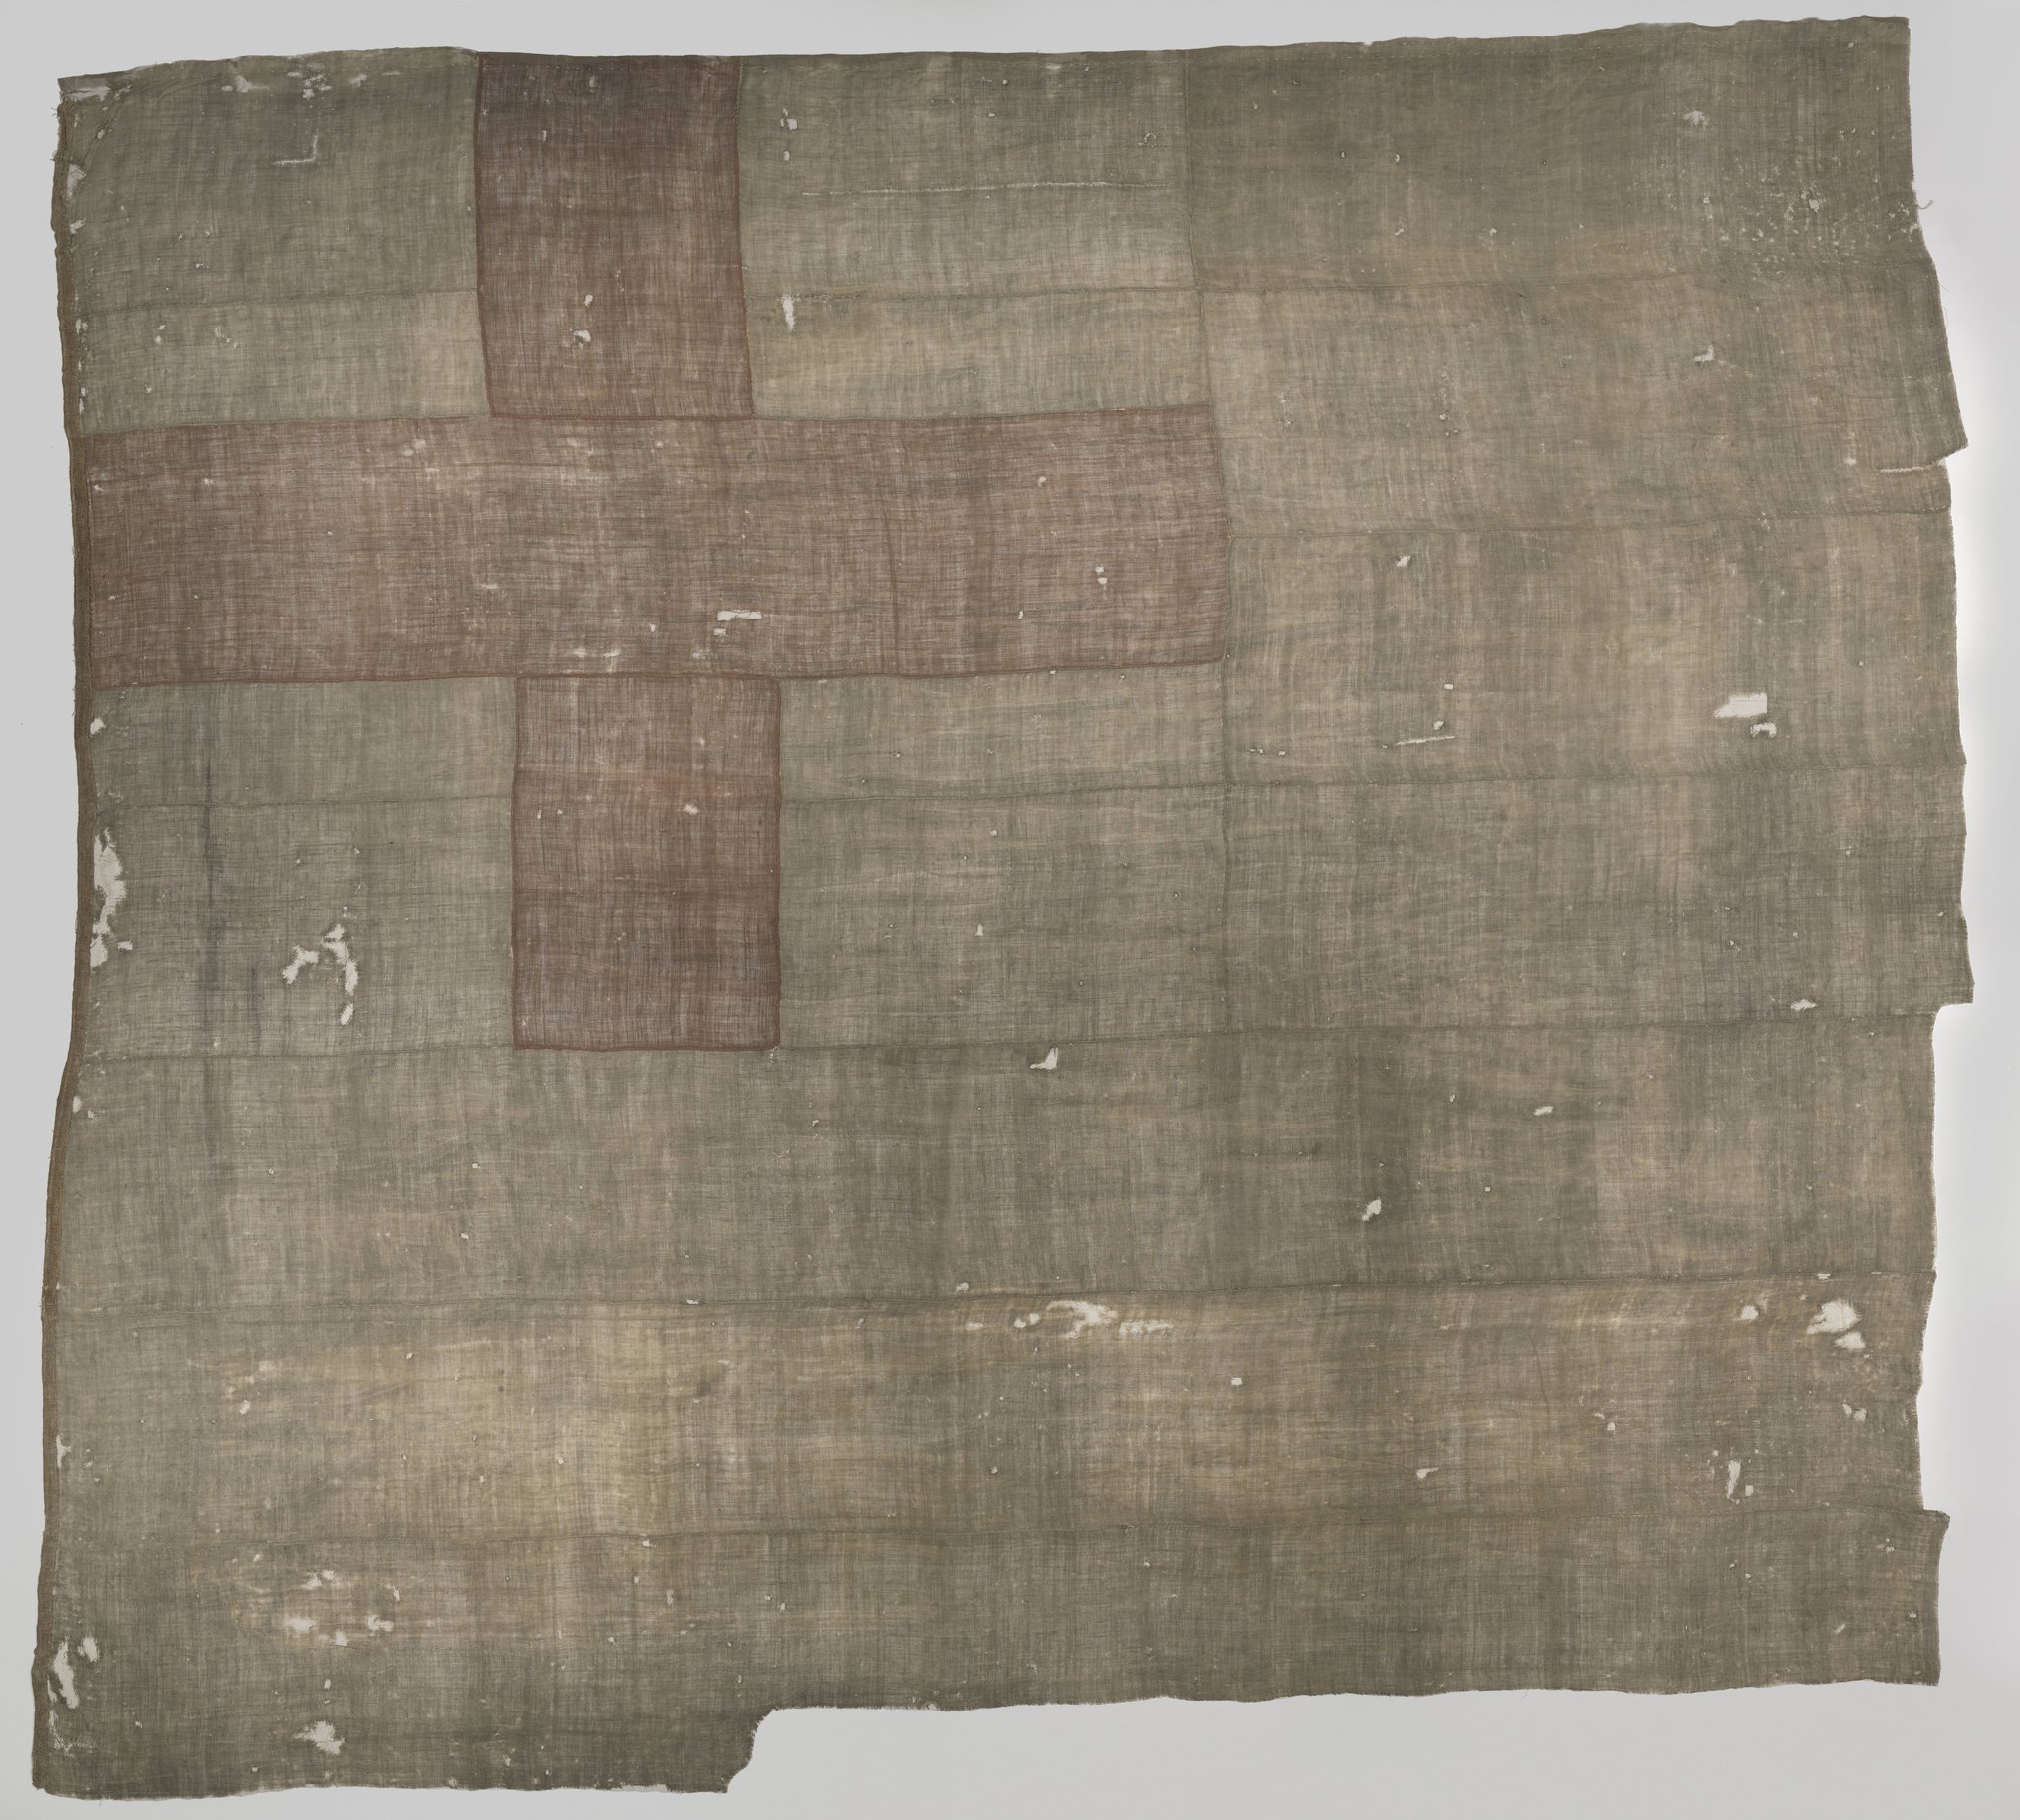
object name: ship flag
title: Fragment of a Ship Flag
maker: Anonymous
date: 1630-1702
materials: wool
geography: england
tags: flag, colours (as symbol of the state, etc.), england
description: Fragment van de broekingzijde van een scheepsvlag, wit met in de bovenhals een witte rechthoek met een rood kruis (St. George's cross). Dit is een witte scheepsvlag van de periode 1630-1702.